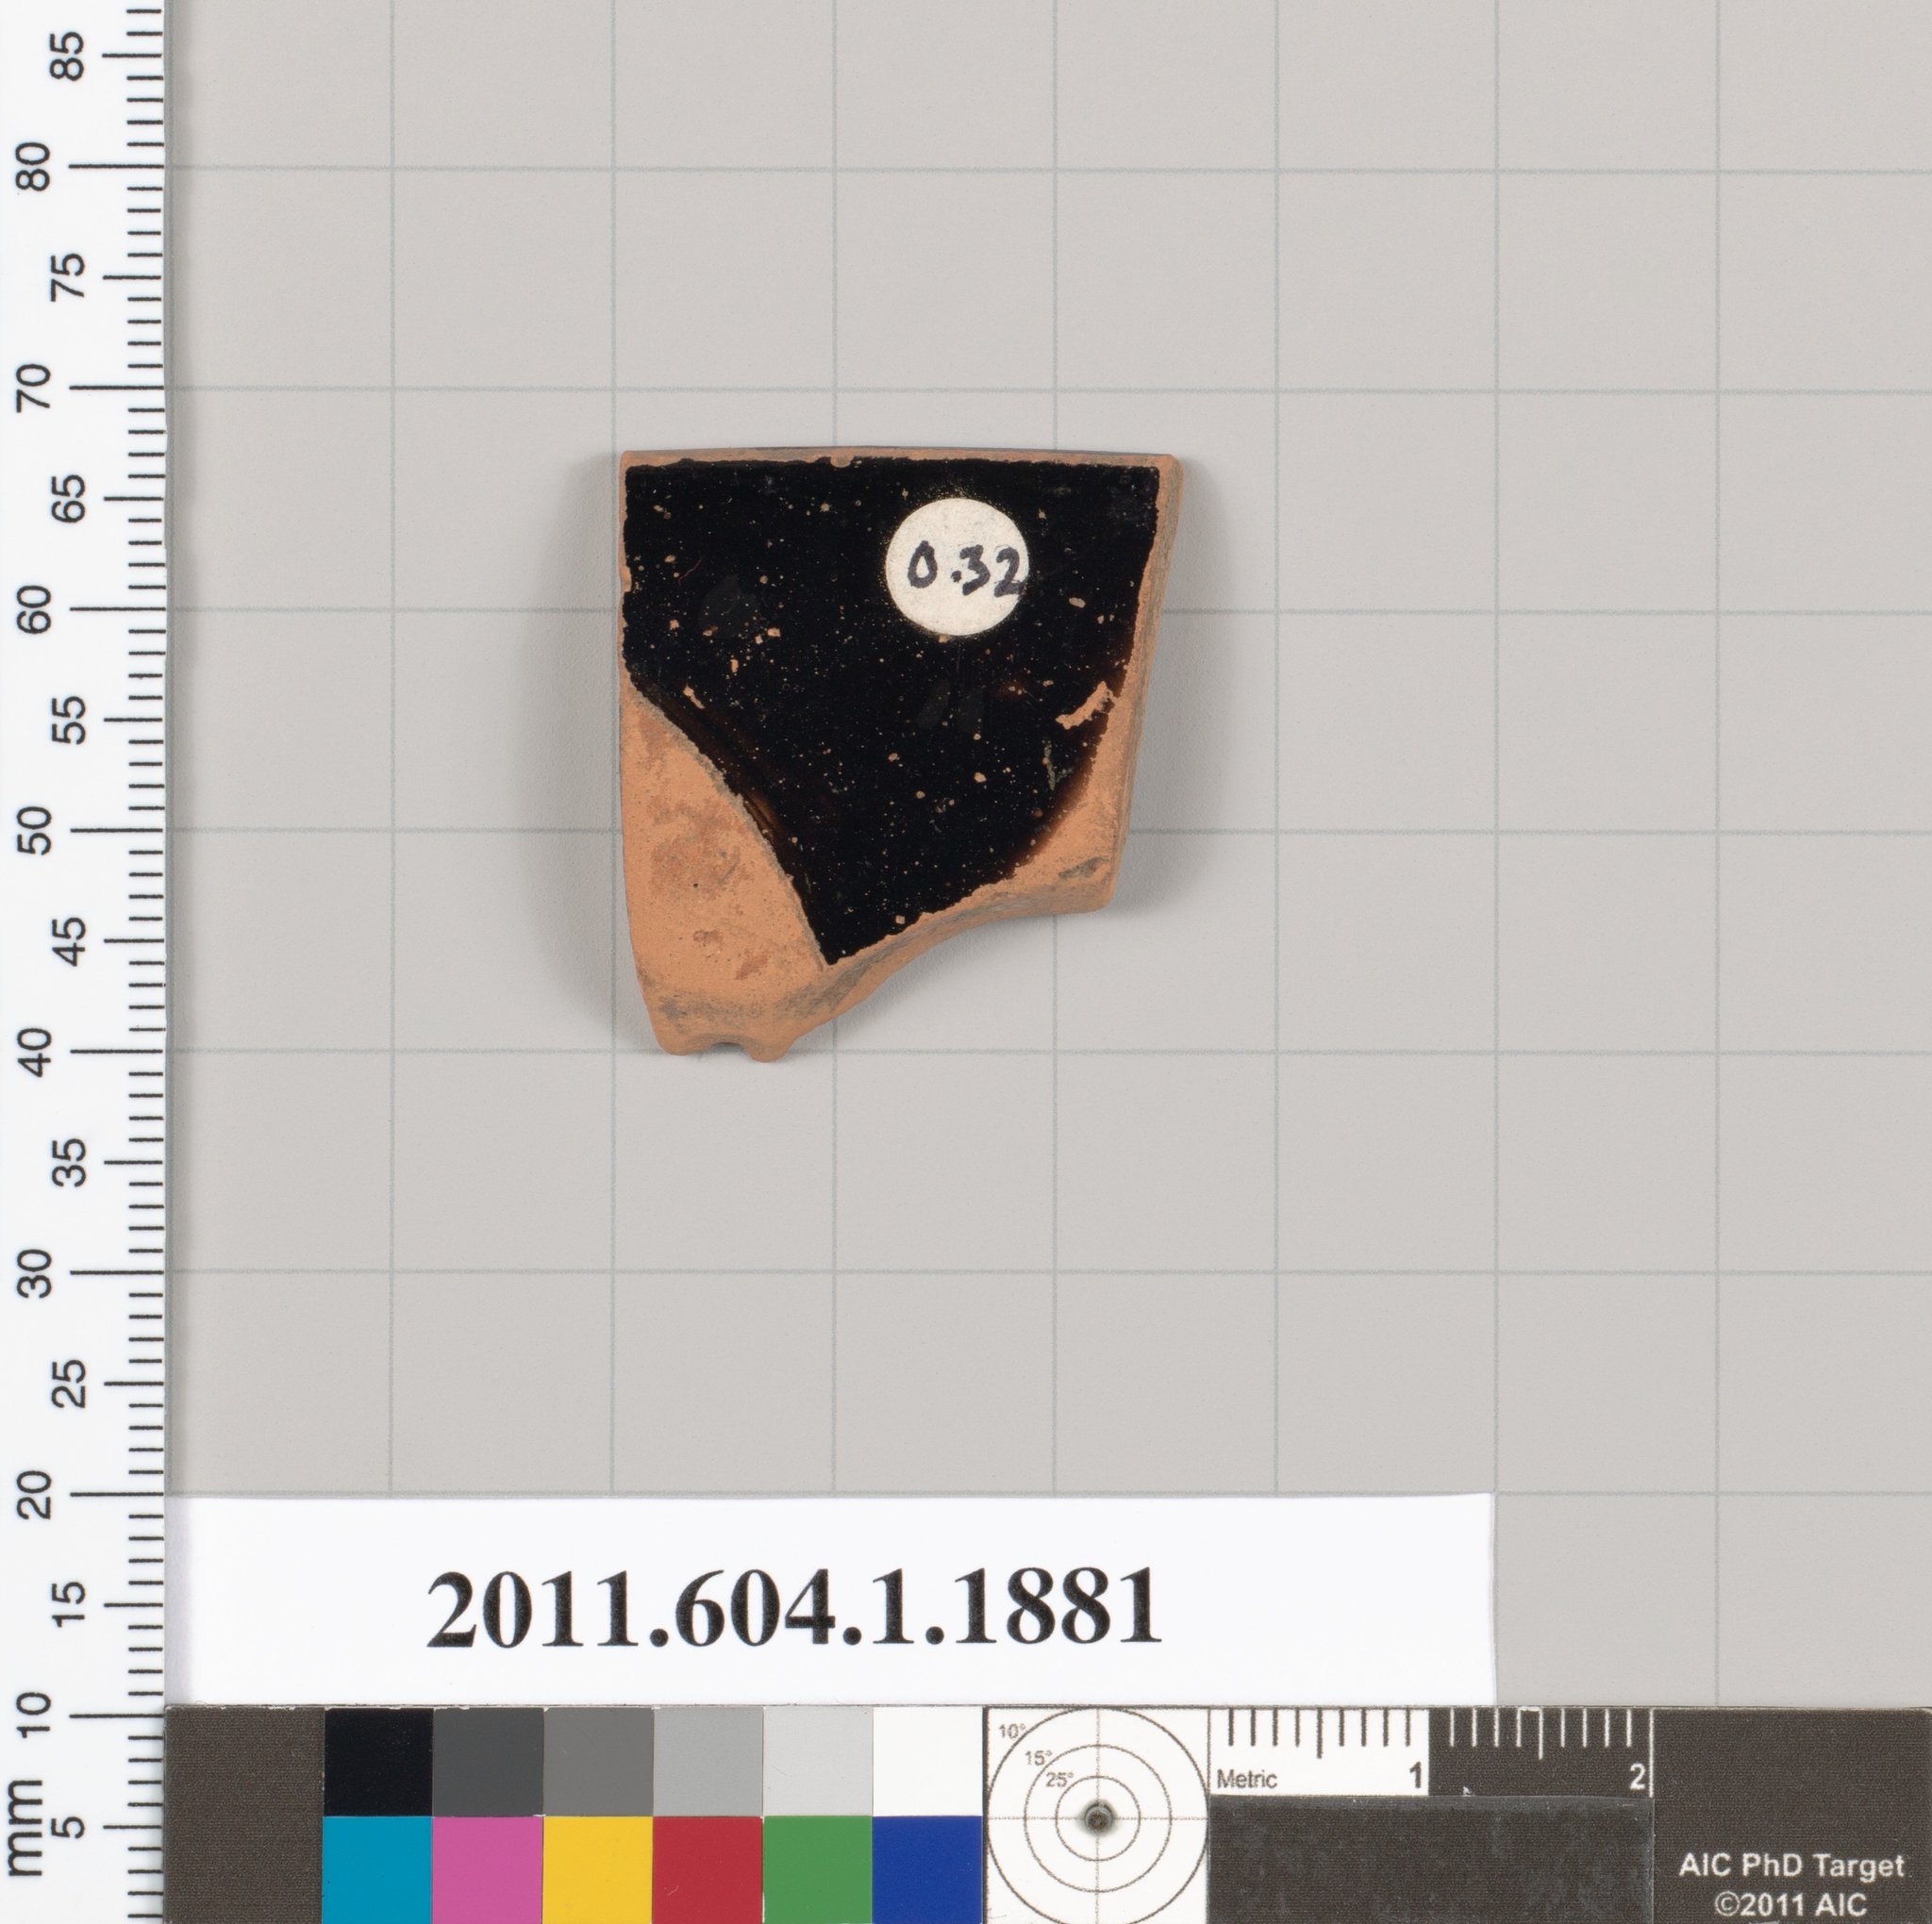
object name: kylix fragment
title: Terracotta rim fragment of a kylix (drinking cup)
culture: greek, attic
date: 500-401 BCE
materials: terracotta